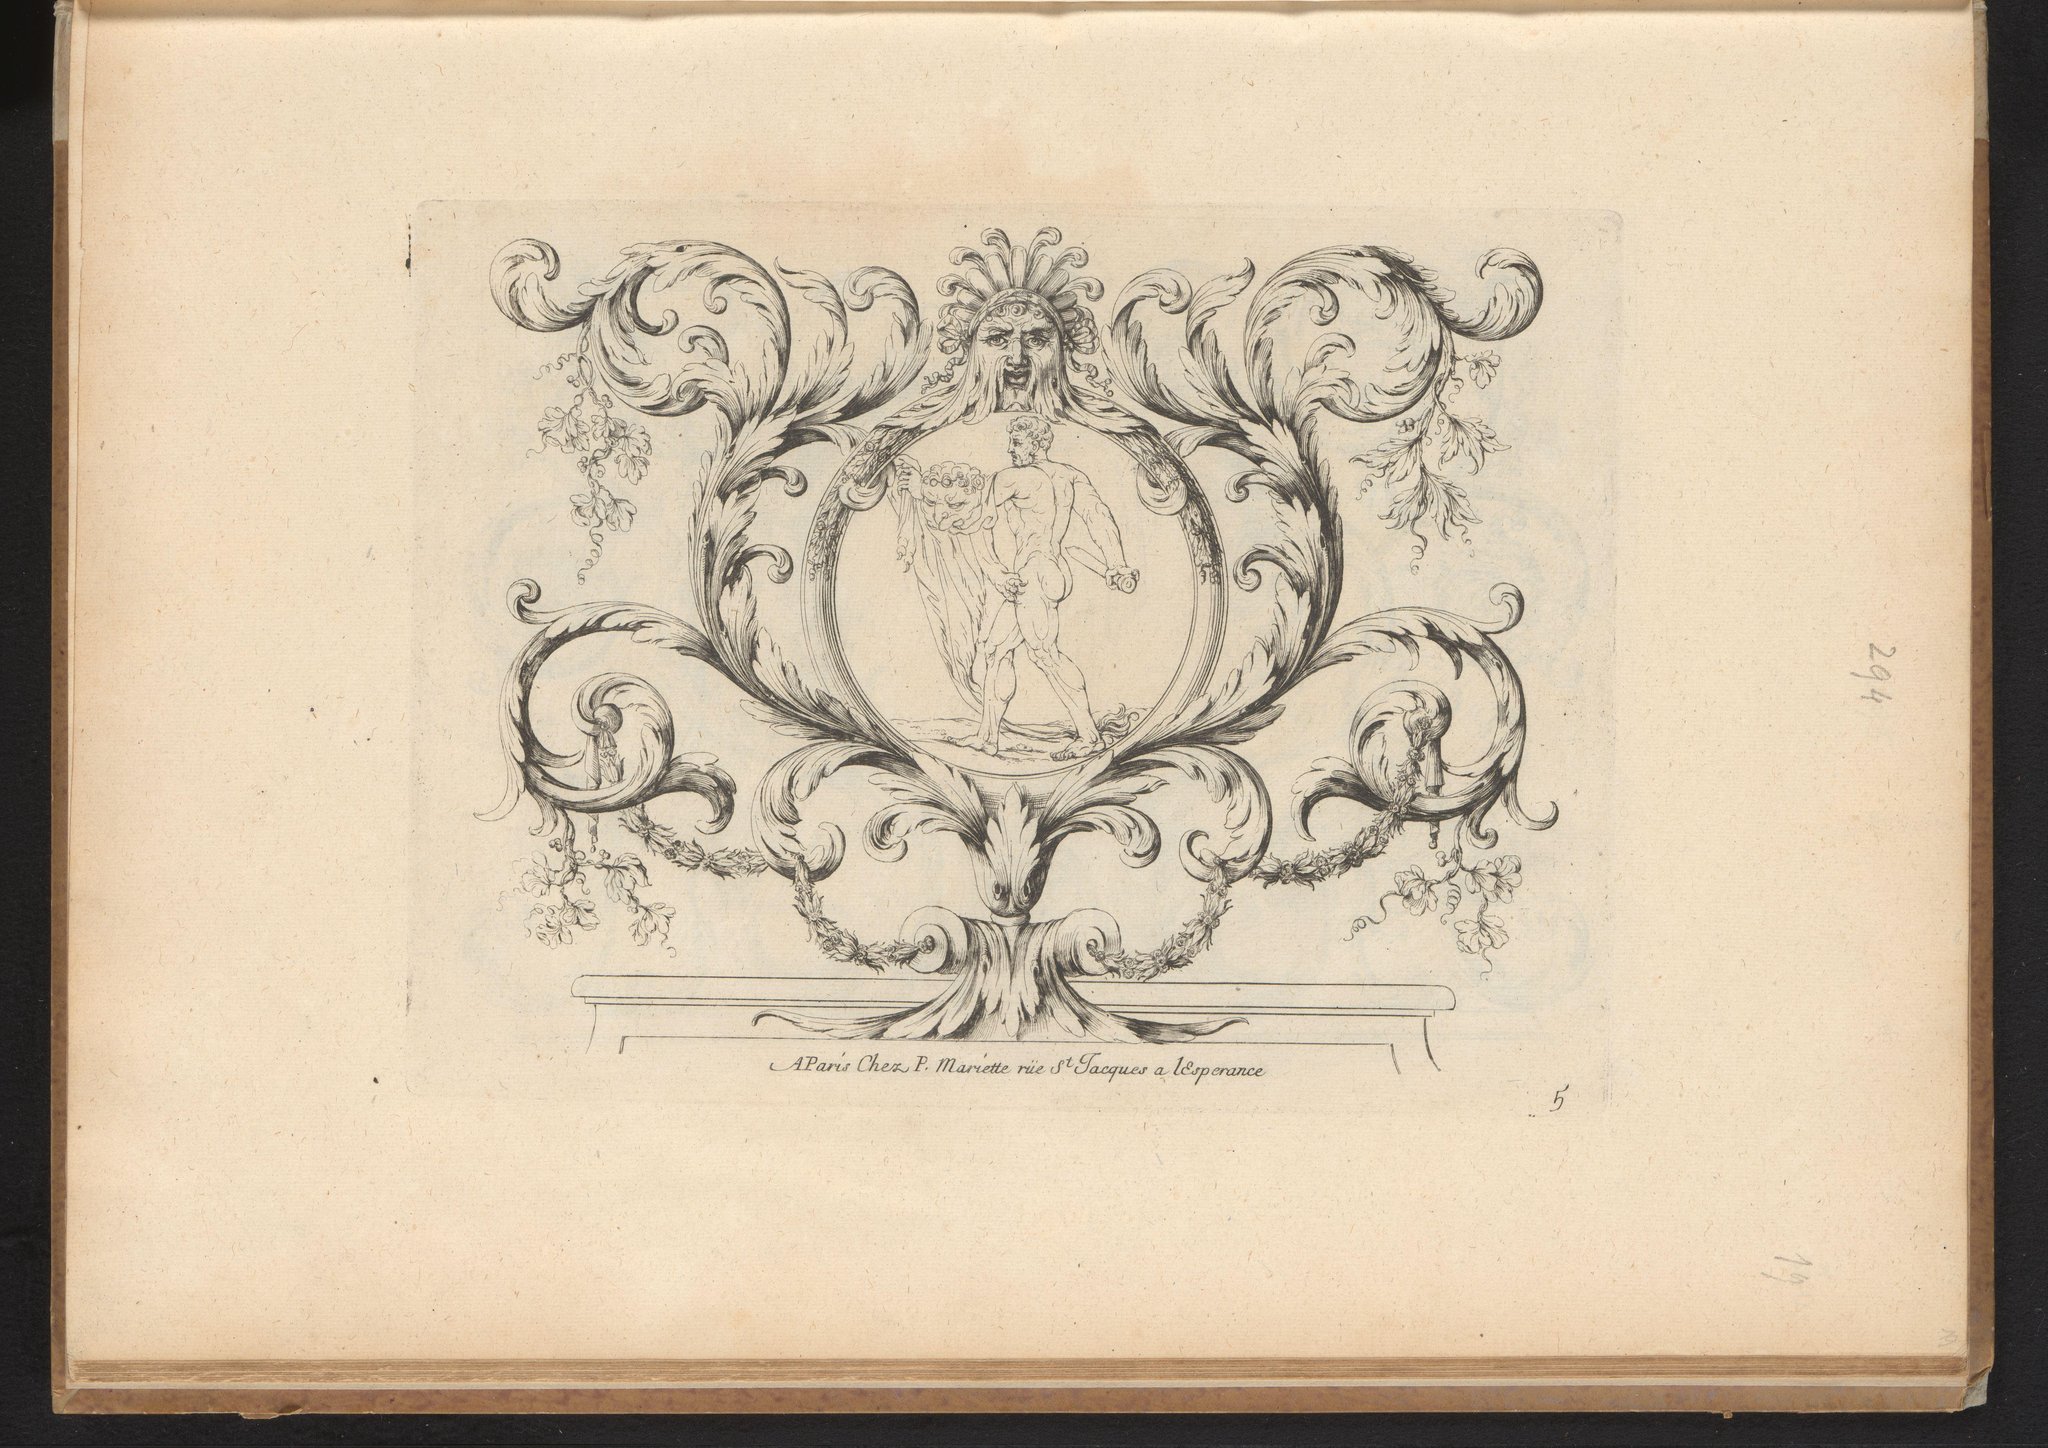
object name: ornament print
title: Panelen met bladmotieven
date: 1660-1690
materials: paper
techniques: etching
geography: paris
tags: attributes of hercules (with name), acanthus ~ ornament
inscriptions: collector's mark: Lugt 2228a, collector's mark: Lugt 2760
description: Deze prent maakt deel uit van een album.